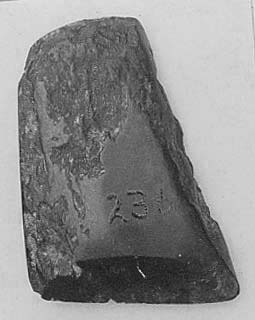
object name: knife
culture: canadian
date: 1902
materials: jade